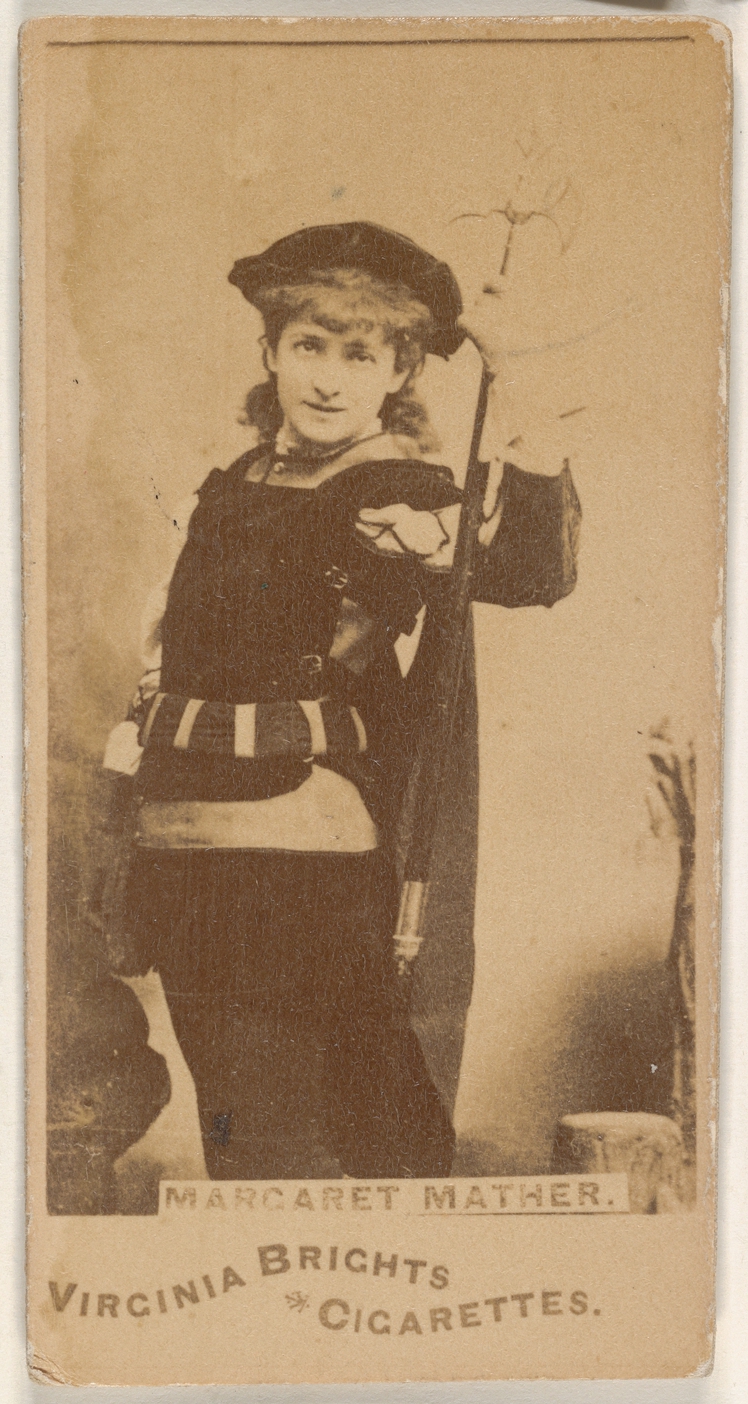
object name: photograph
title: Margaret Mather, from the Actors and Actresses series (N45, Type 1) for Virginia Brights Cigarettes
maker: allen & ginter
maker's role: publisher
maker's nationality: american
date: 1888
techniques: albumen silver print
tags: portraits,women,actresses